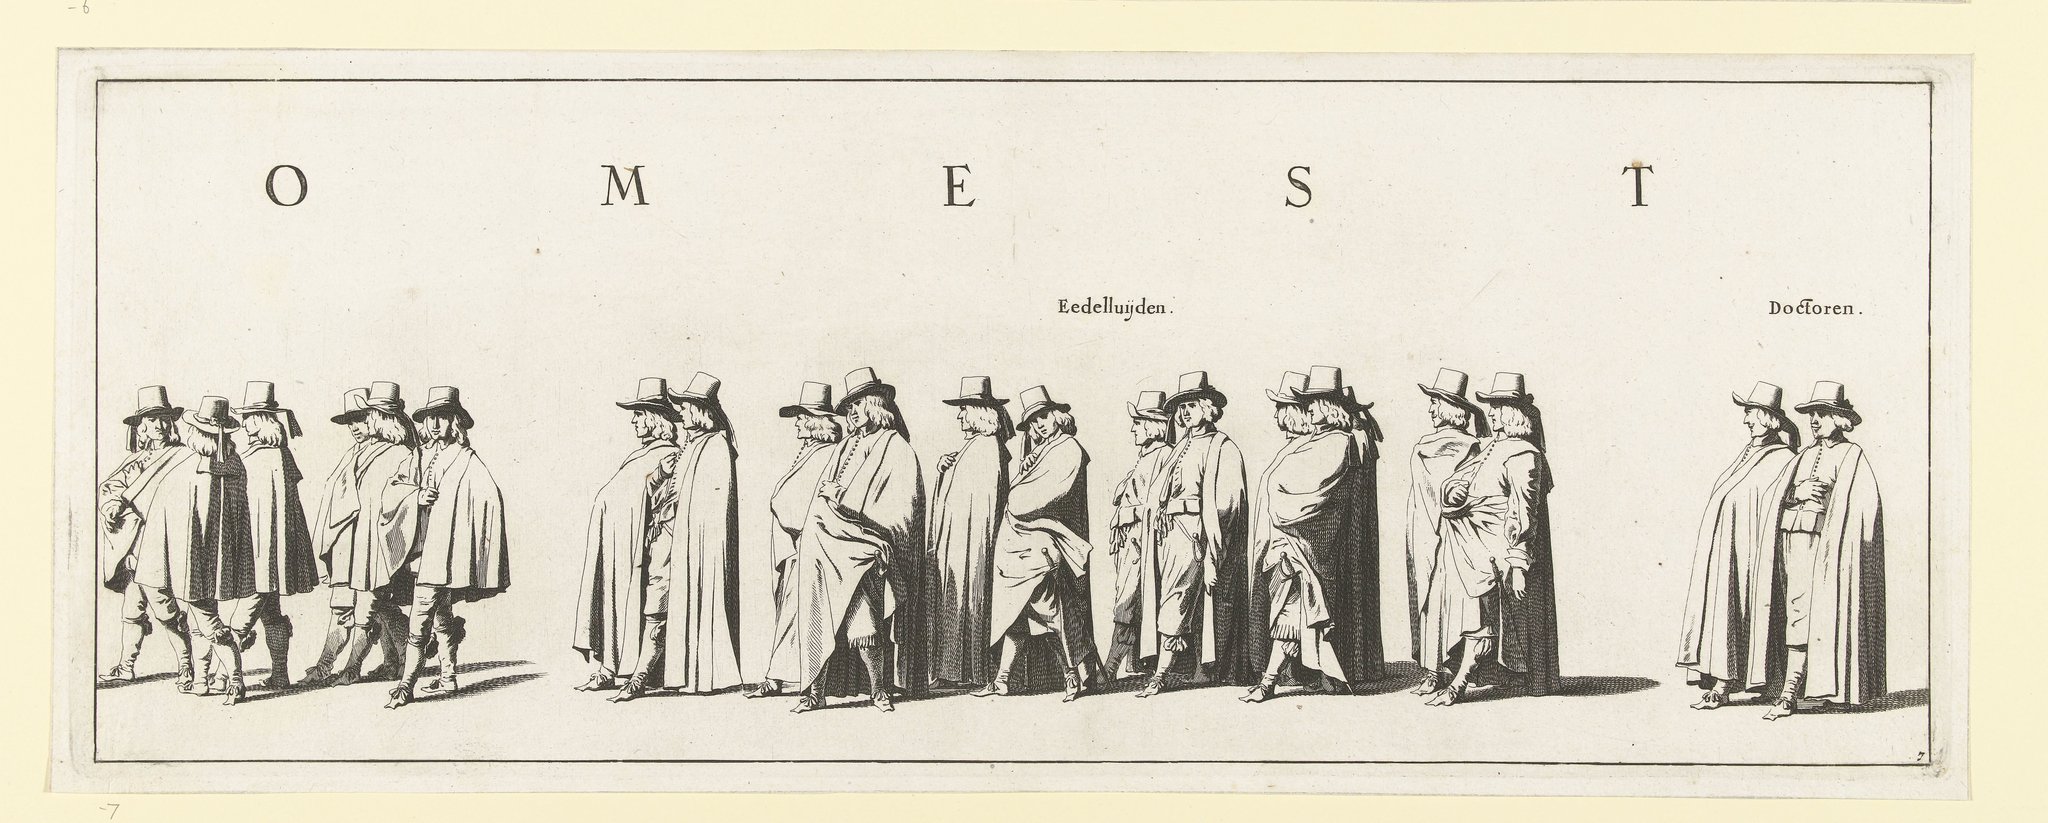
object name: print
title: De begrafenisstoet van Frederik Hendrik (plaat nr. 7), 1647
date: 1647-1651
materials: paper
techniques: etching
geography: northern netherlands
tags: delft, frederick henry (prince of orange), cortege, funeral procession, the hague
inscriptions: collector's mark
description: De begrafenisstoet van stadhouder Frederik Hendrik te 's-Gravenhage op 10 mei 1647. Plaat nr. 7 met een deel van de stoet, boven de personen staat hun functie. Onderdeel van een serie van 30 platen en 20 tekstbladen, bedoeld om aan elkaar geplakt te worden.